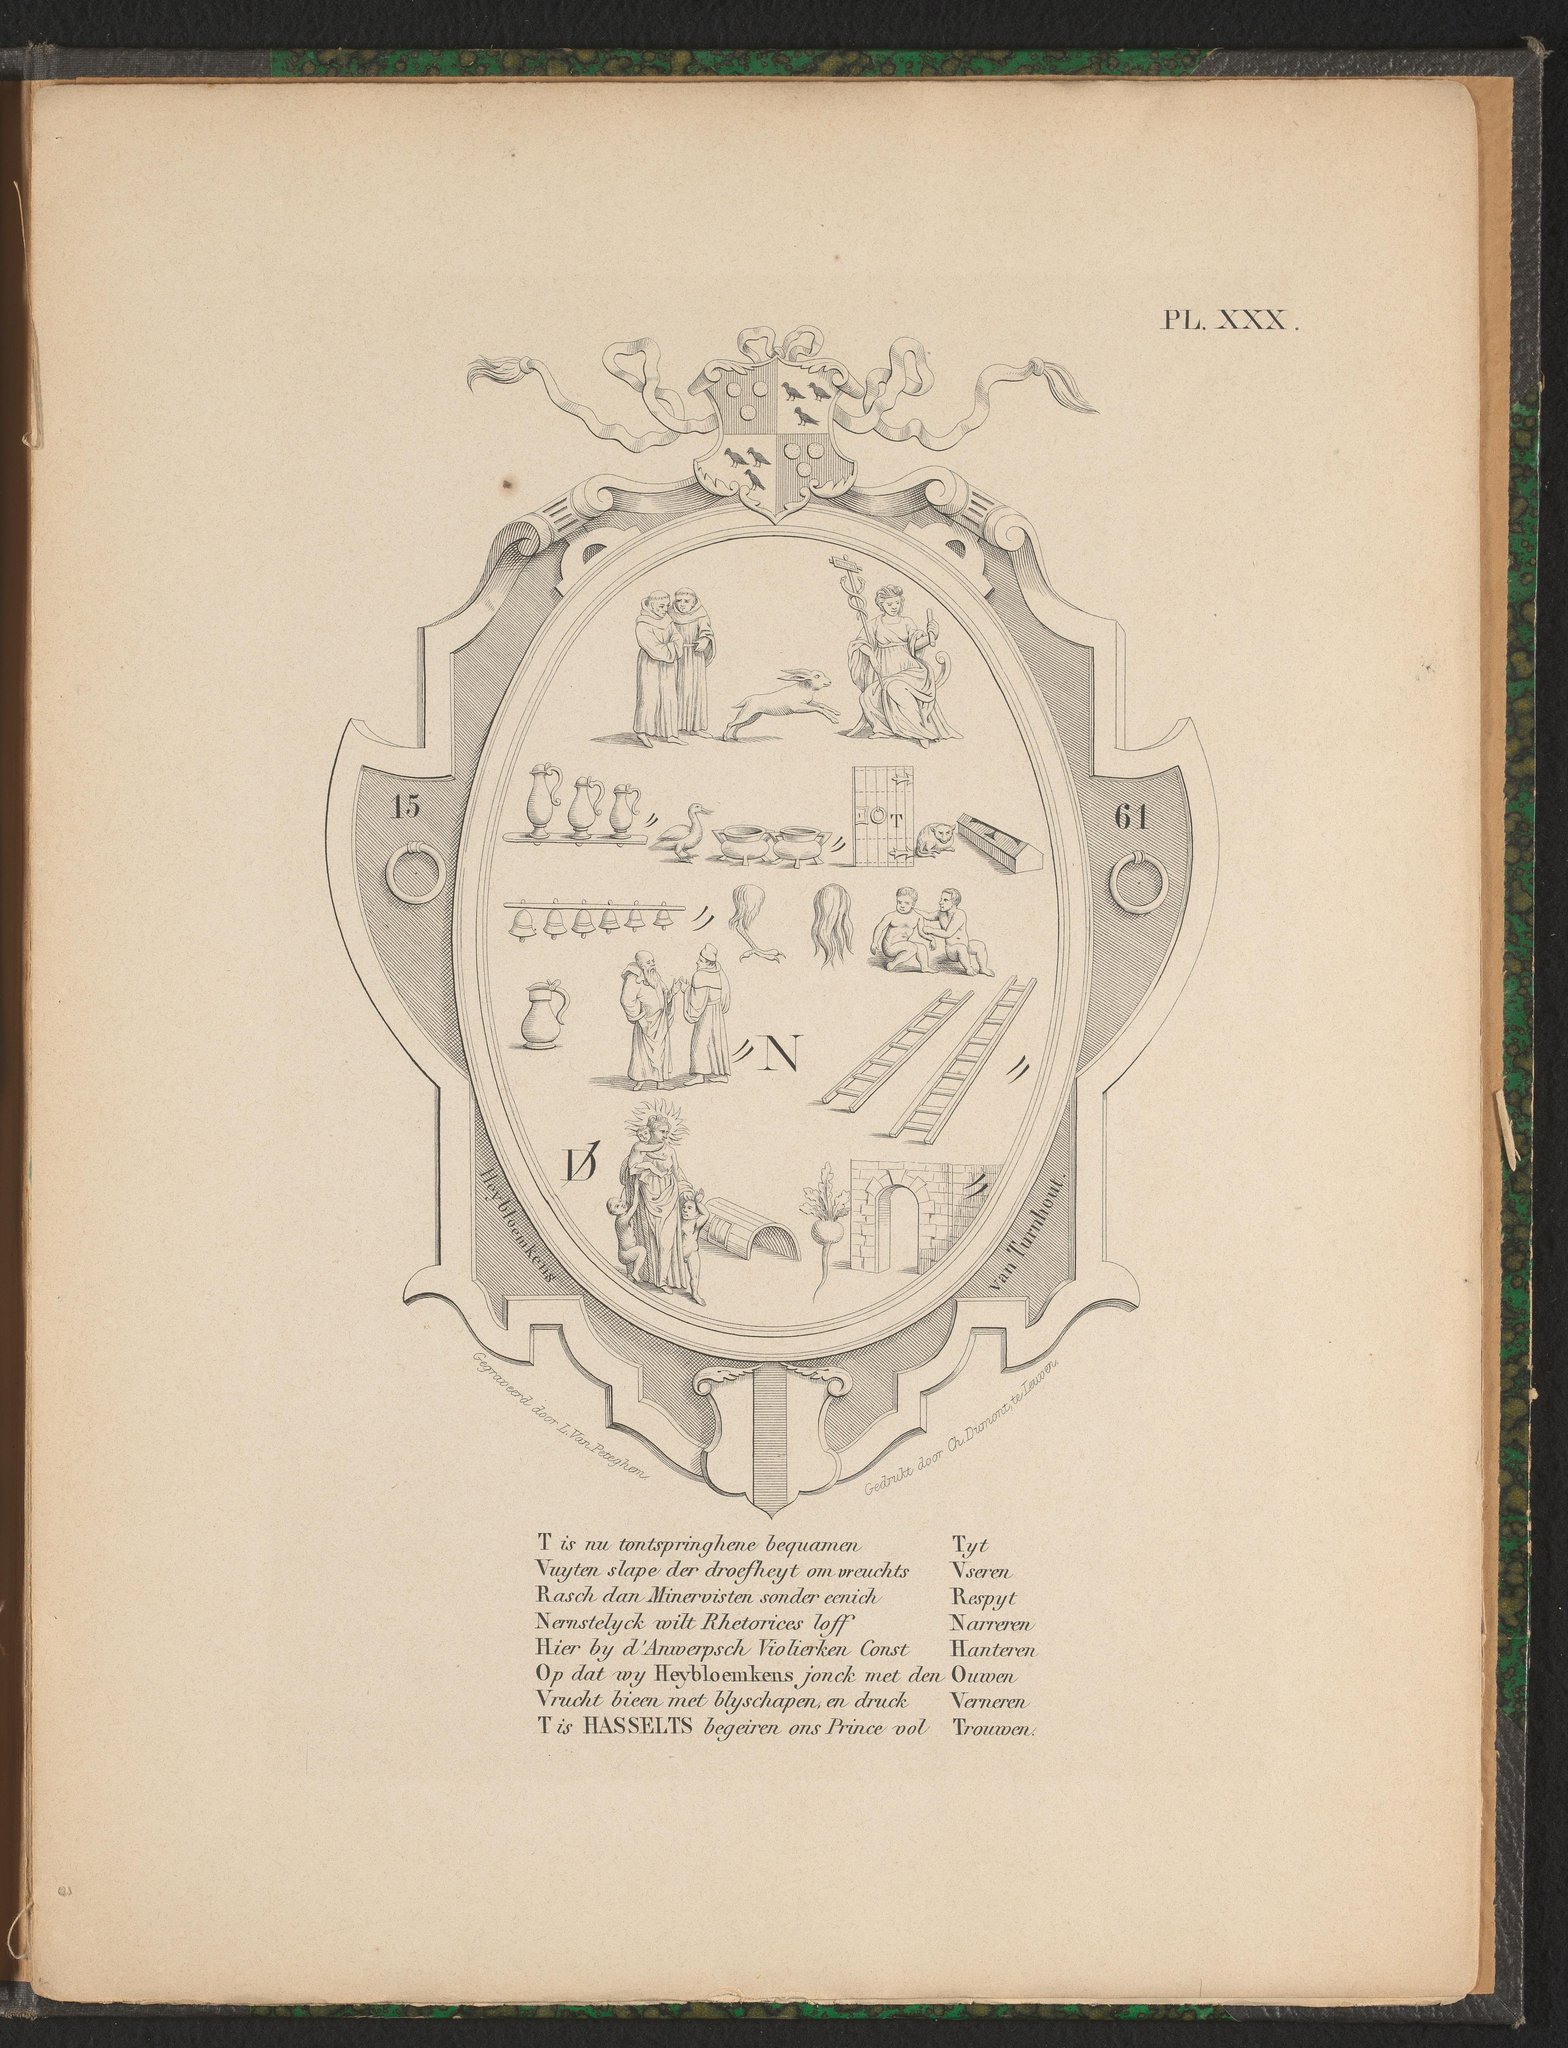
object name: historical object representation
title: Rebusblazoen van De Heibloem (Turnhout), 1561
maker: l. van peteghem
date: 1859-1861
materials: paper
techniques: lithograph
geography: belgium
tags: chamber of rhetoric (dutch: 'rederijkerskamer'), rebus, antwerp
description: Rebusblazoen van De Heibloem, rederijkerskamers van Turnhout, 1561. Plaat XXX in een map met 35 genummerde platen, de meeste naar de illustraties in de oorspronkelijke uitgave van het Landjuweel van Antwerpen in 1561.